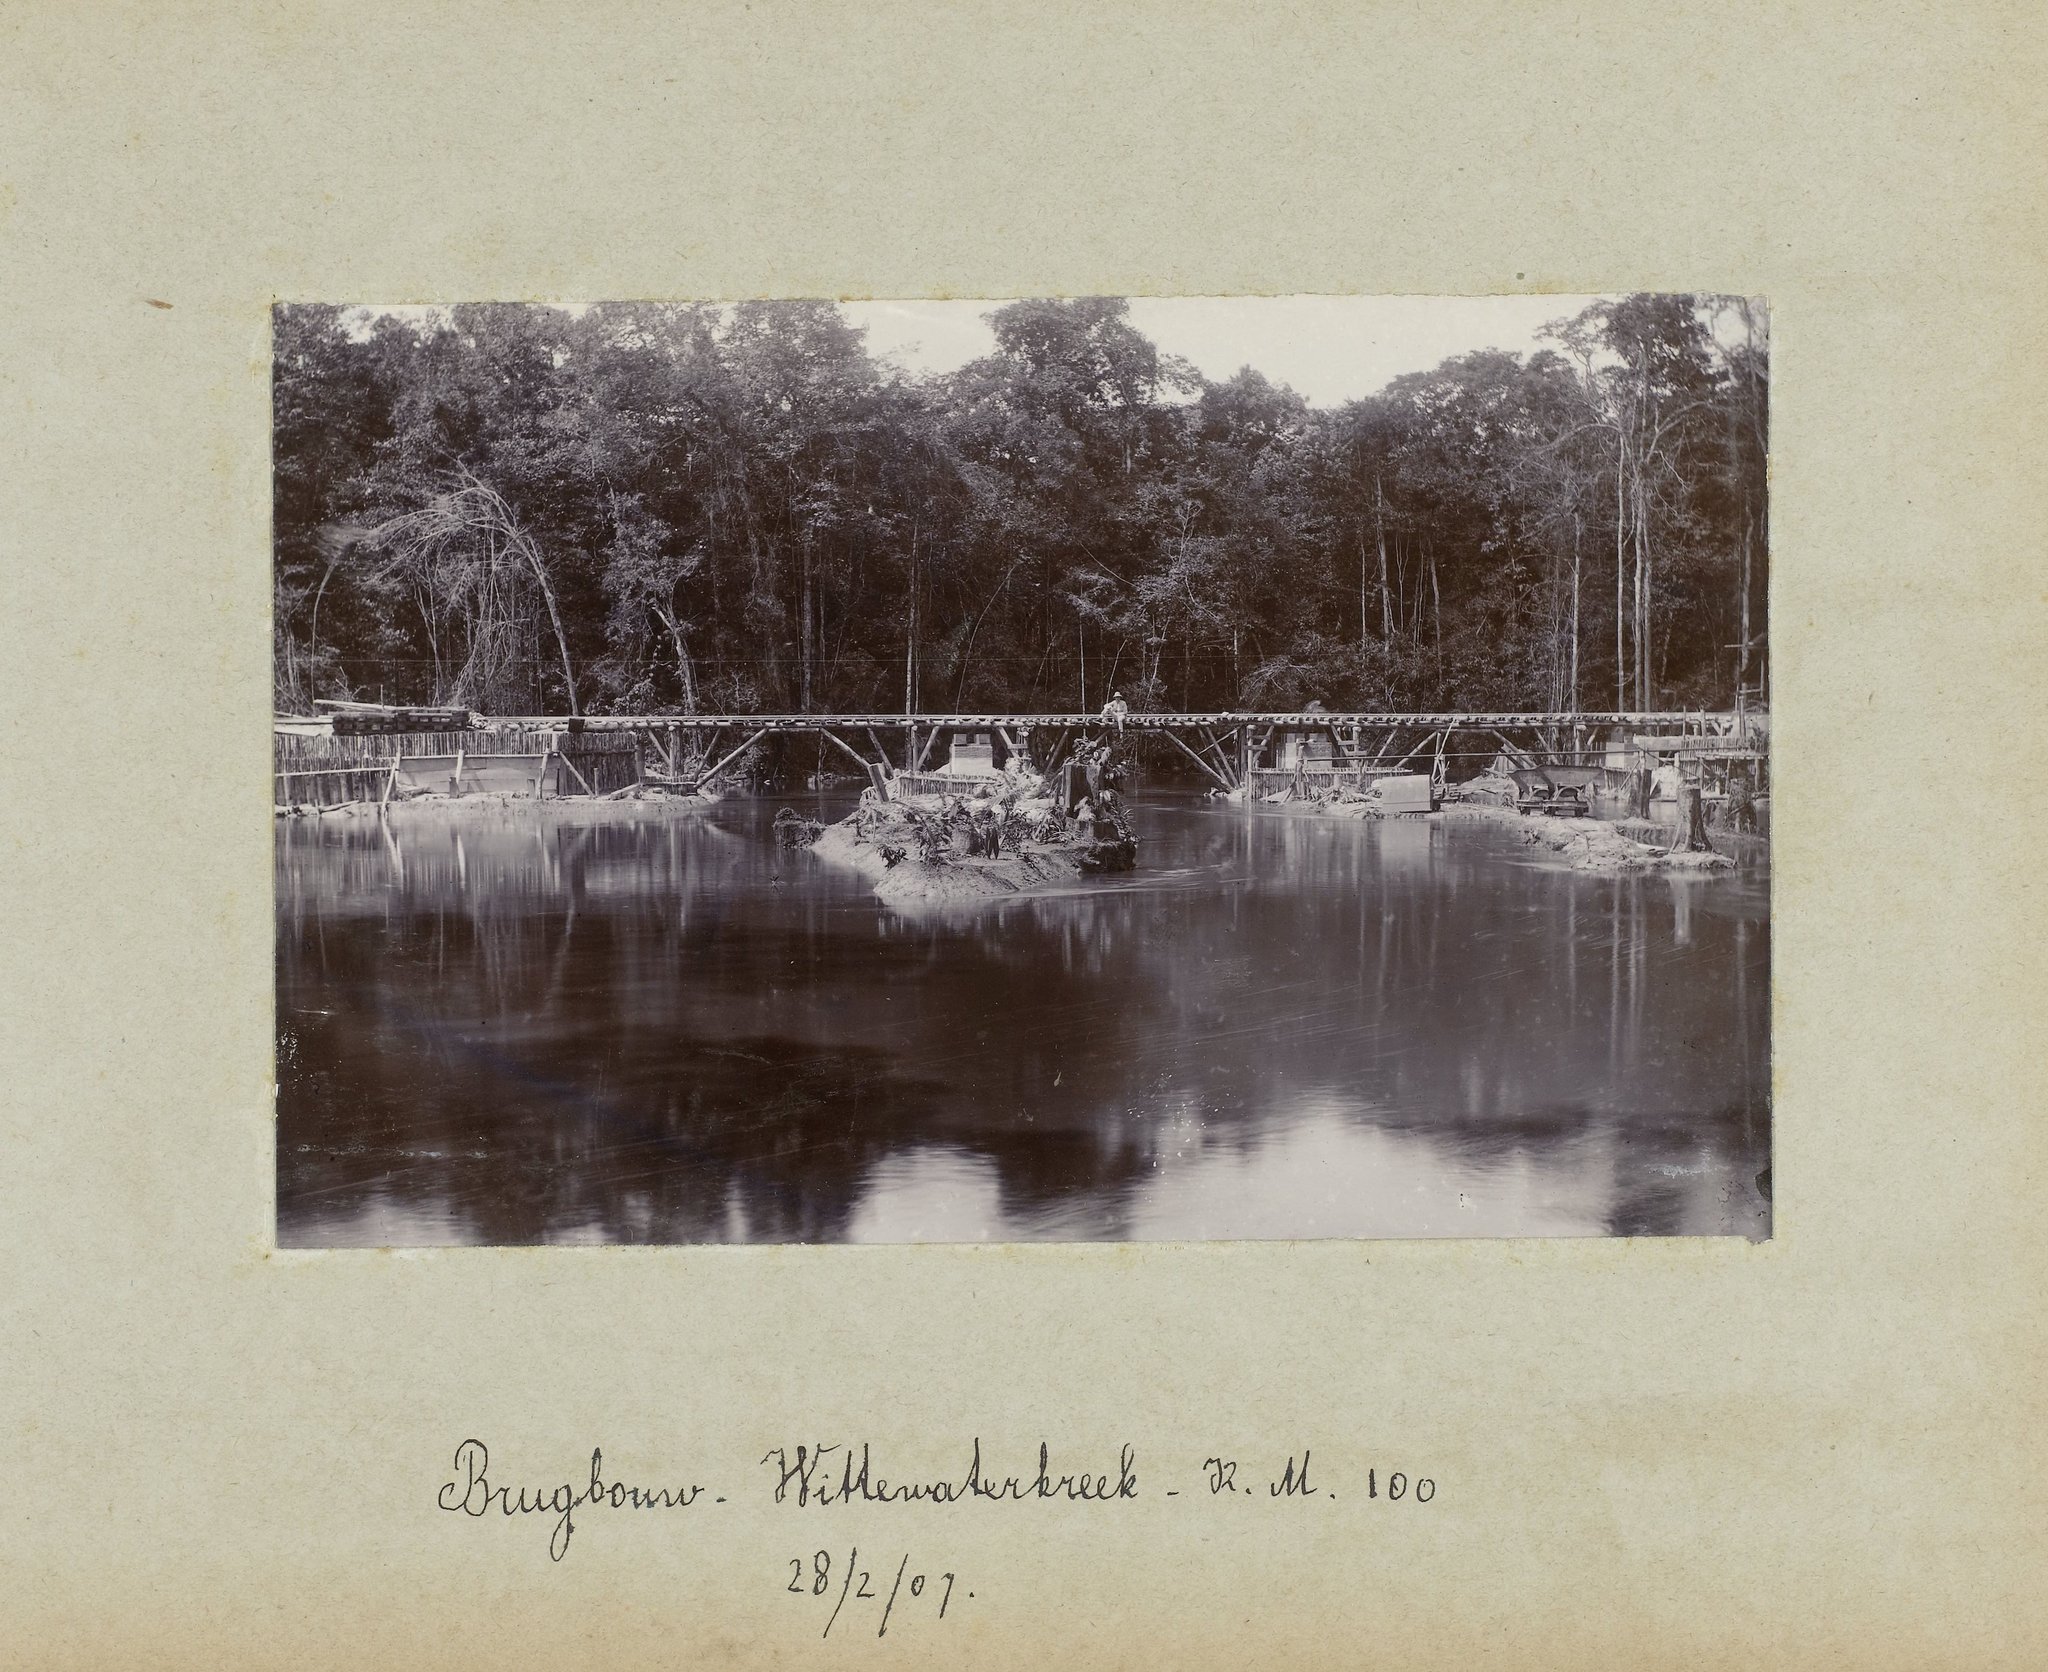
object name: photograph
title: Brugbouw Wittewaterkreek - K.M. 100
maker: augusta curiel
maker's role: fotograaf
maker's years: 1873-1937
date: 1907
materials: photographic support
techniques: photography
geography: suriname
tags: jacob evert wesenhagen, railway, tramway; rack railway, suriname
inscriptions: inscription: ‘Brugbouw Wittewaterkreek - K.M. 100 28/2/07.’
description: Aanleg van de brug over de Wittewater kreek (Wittiewatra). Foto in het fotoalbum over de aanleg van de Lawaspoorweg in Suriname in de jaren 1903-1912. Onderdeel van een groep objecten afkomstig van de familie Wesenhagen in Suriname.